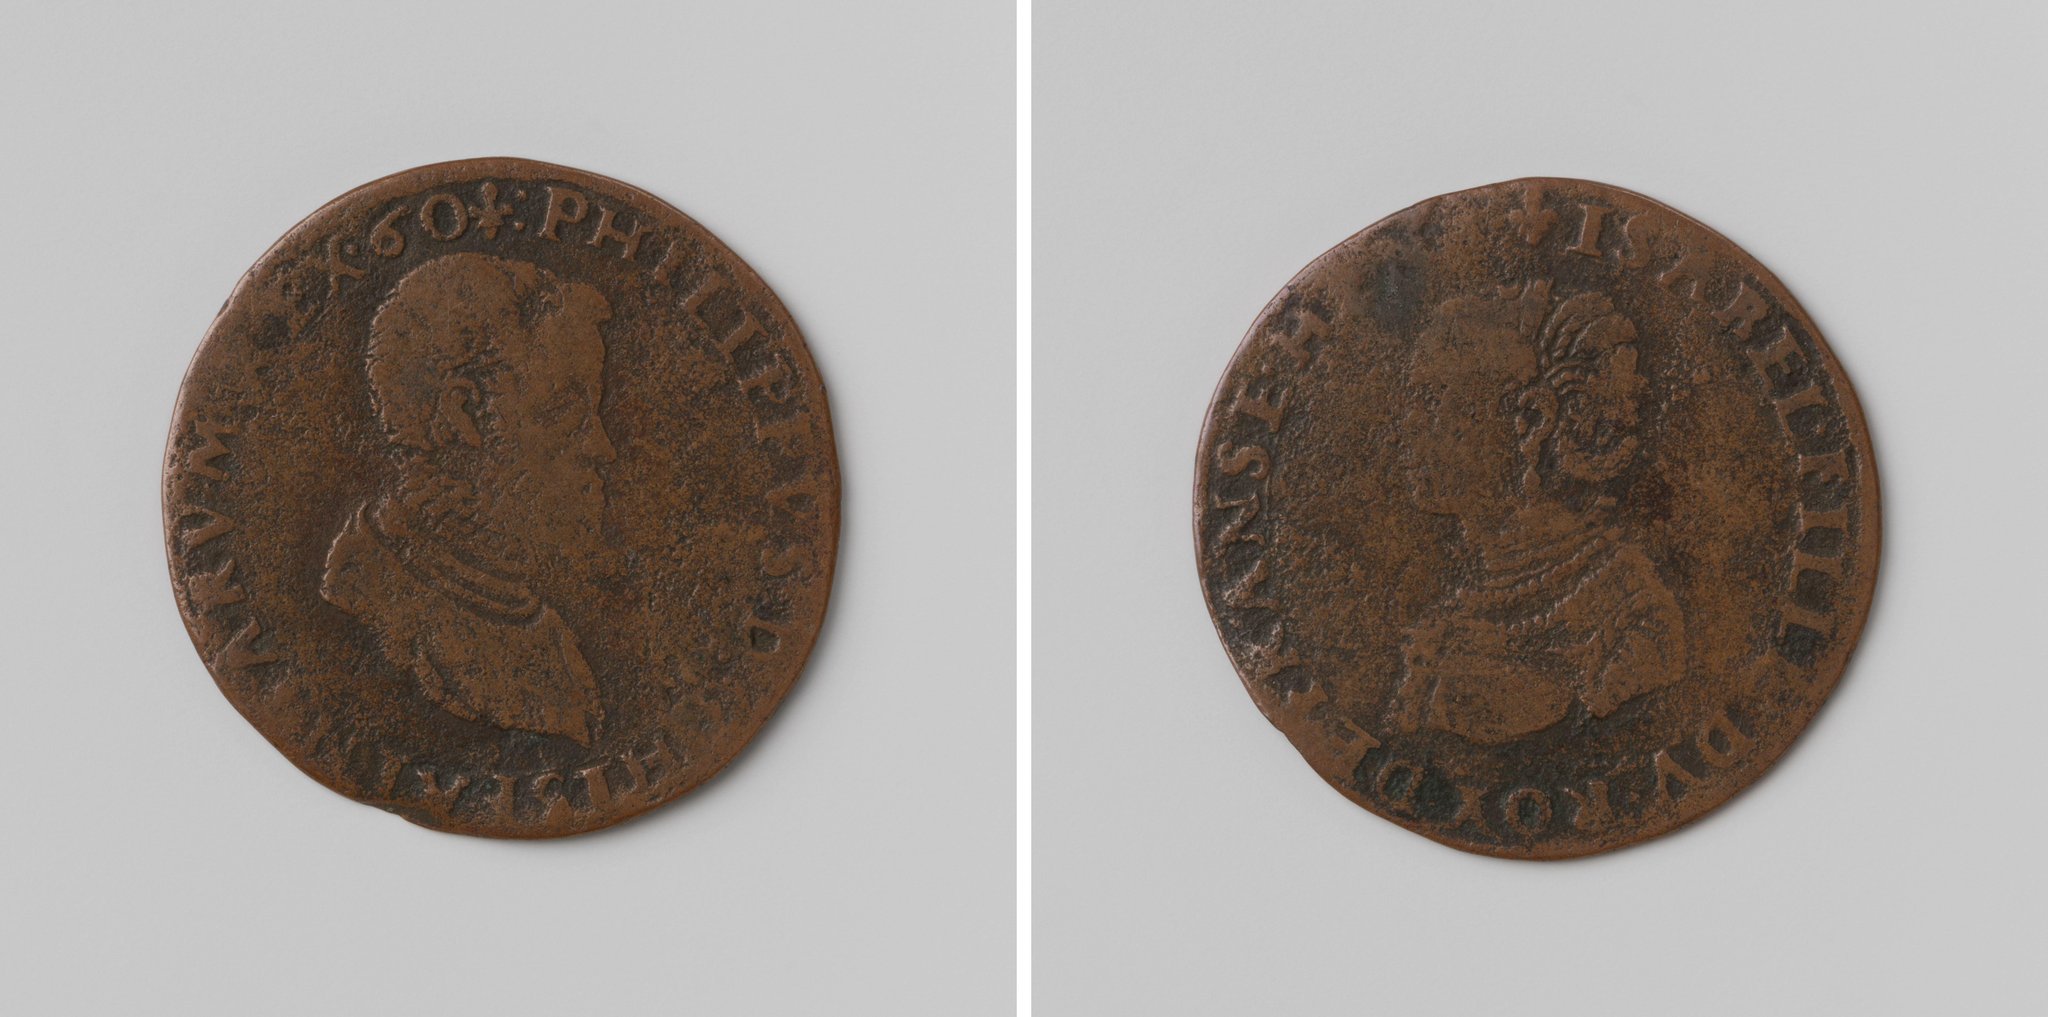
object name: jeton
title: Filips II en Isabella, koning en koningin van Spanje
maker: Anonymous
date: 1560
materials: copper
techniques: striking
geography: wallonia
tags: philip ii of spain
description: Koperen penning. Voorzijde: borststuk man binnen omschrift. Keerzijde: borststuk vrouw binnen omschrift